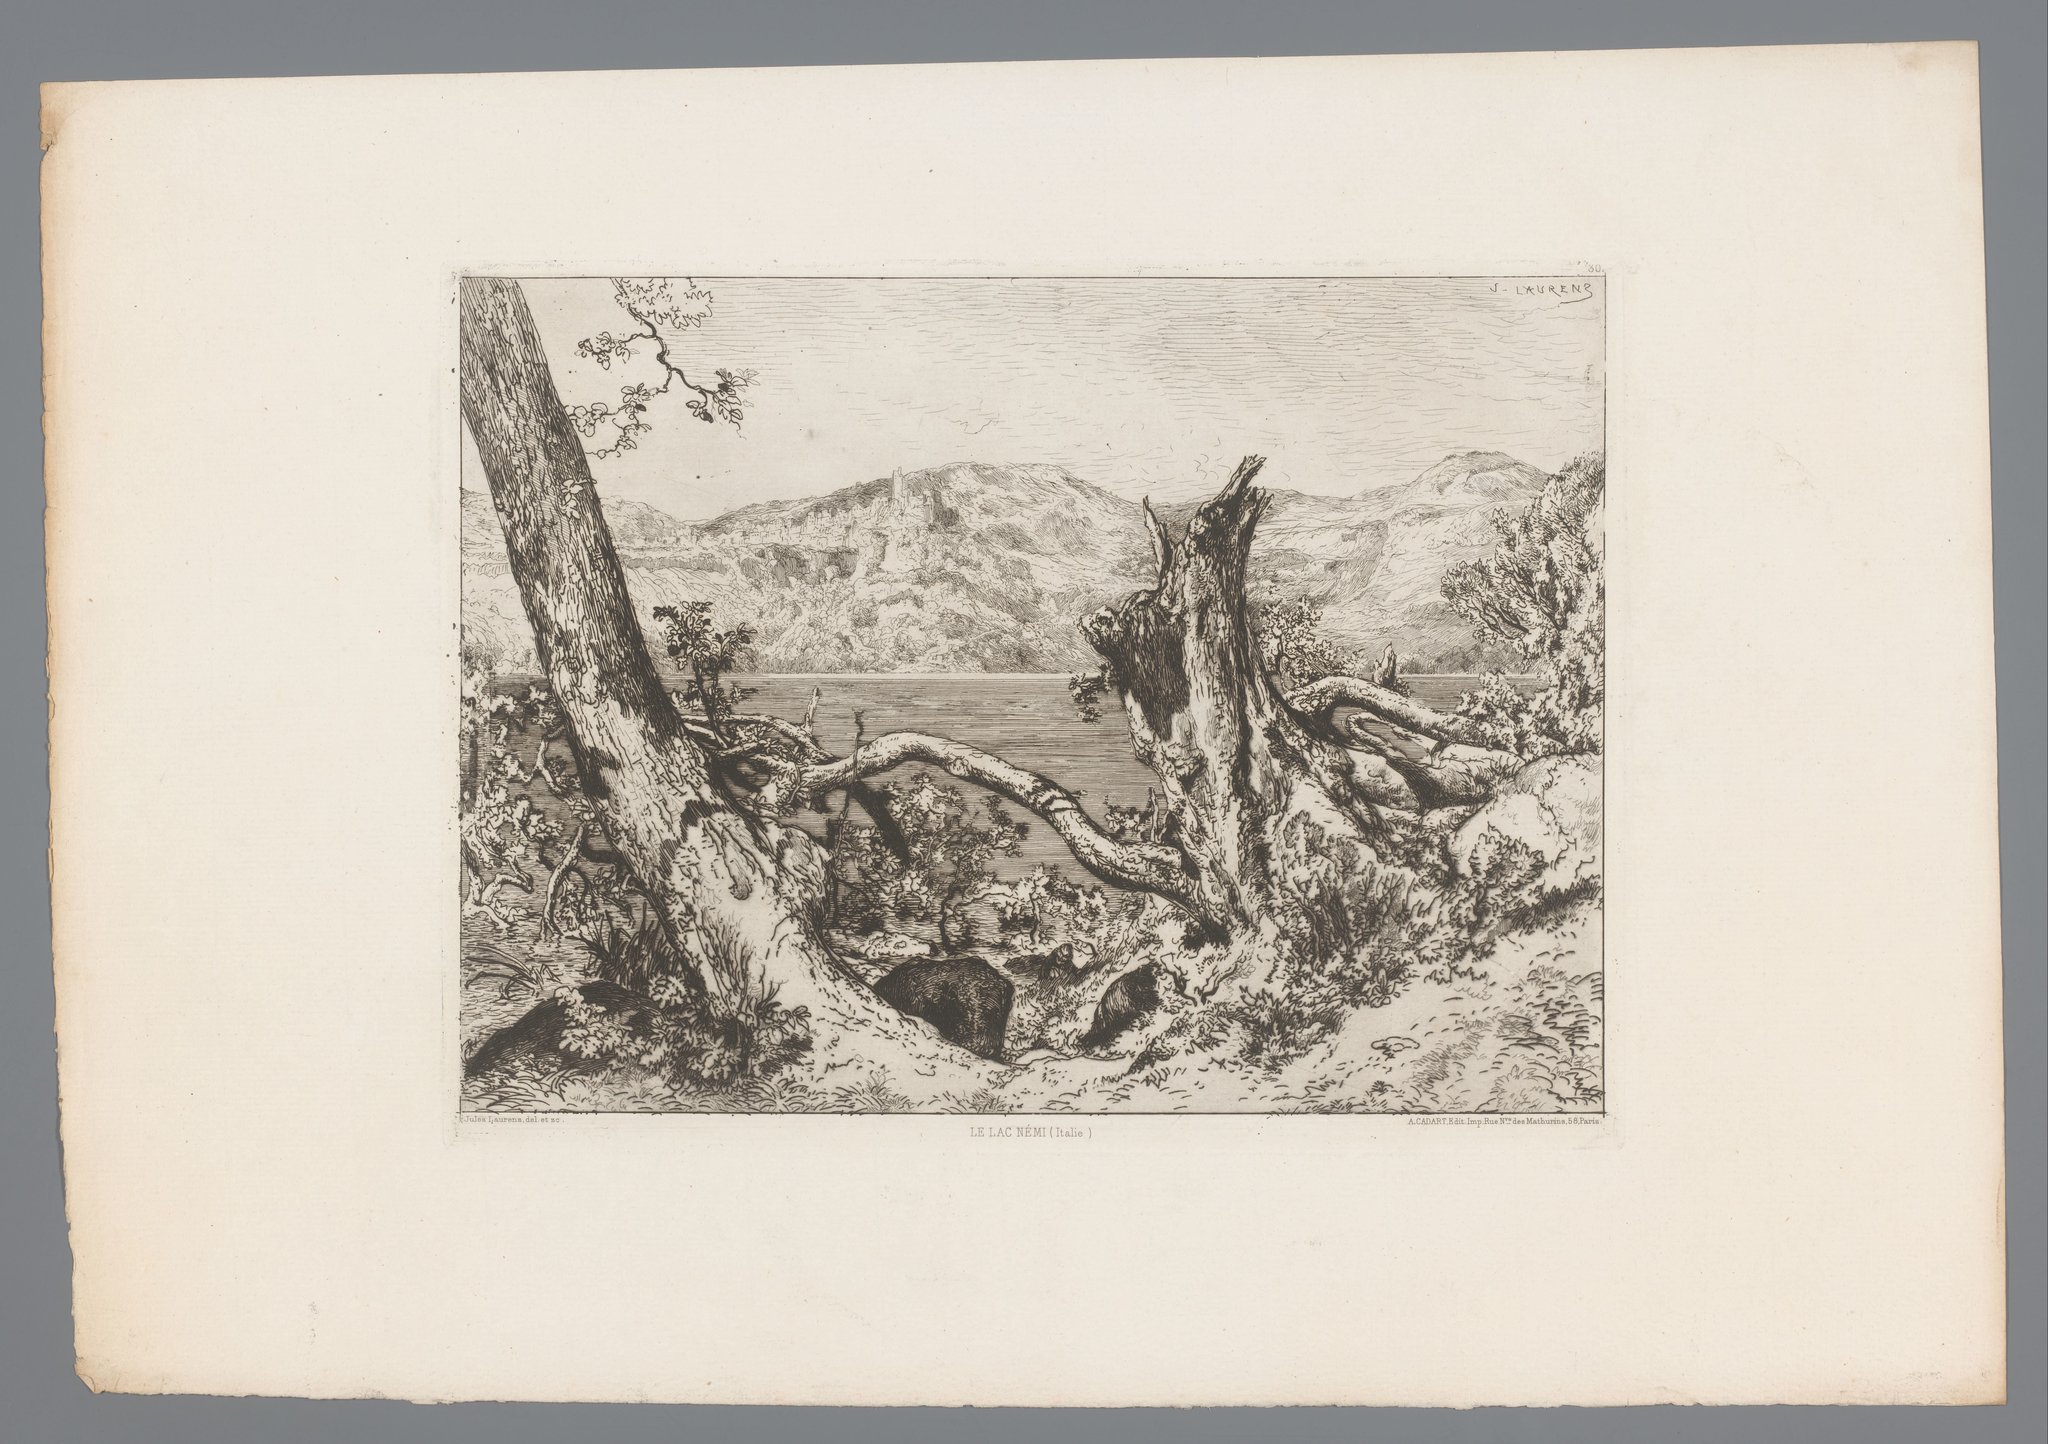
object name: print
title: Franse etsen uit 1874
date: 1874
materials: paper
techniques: drypoint, etching, intaglio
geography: paris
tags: lake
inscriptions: collector's mark: Lugt 2760, collector's mark: ‘AFE v S’, collector's mark: Lugt 2228